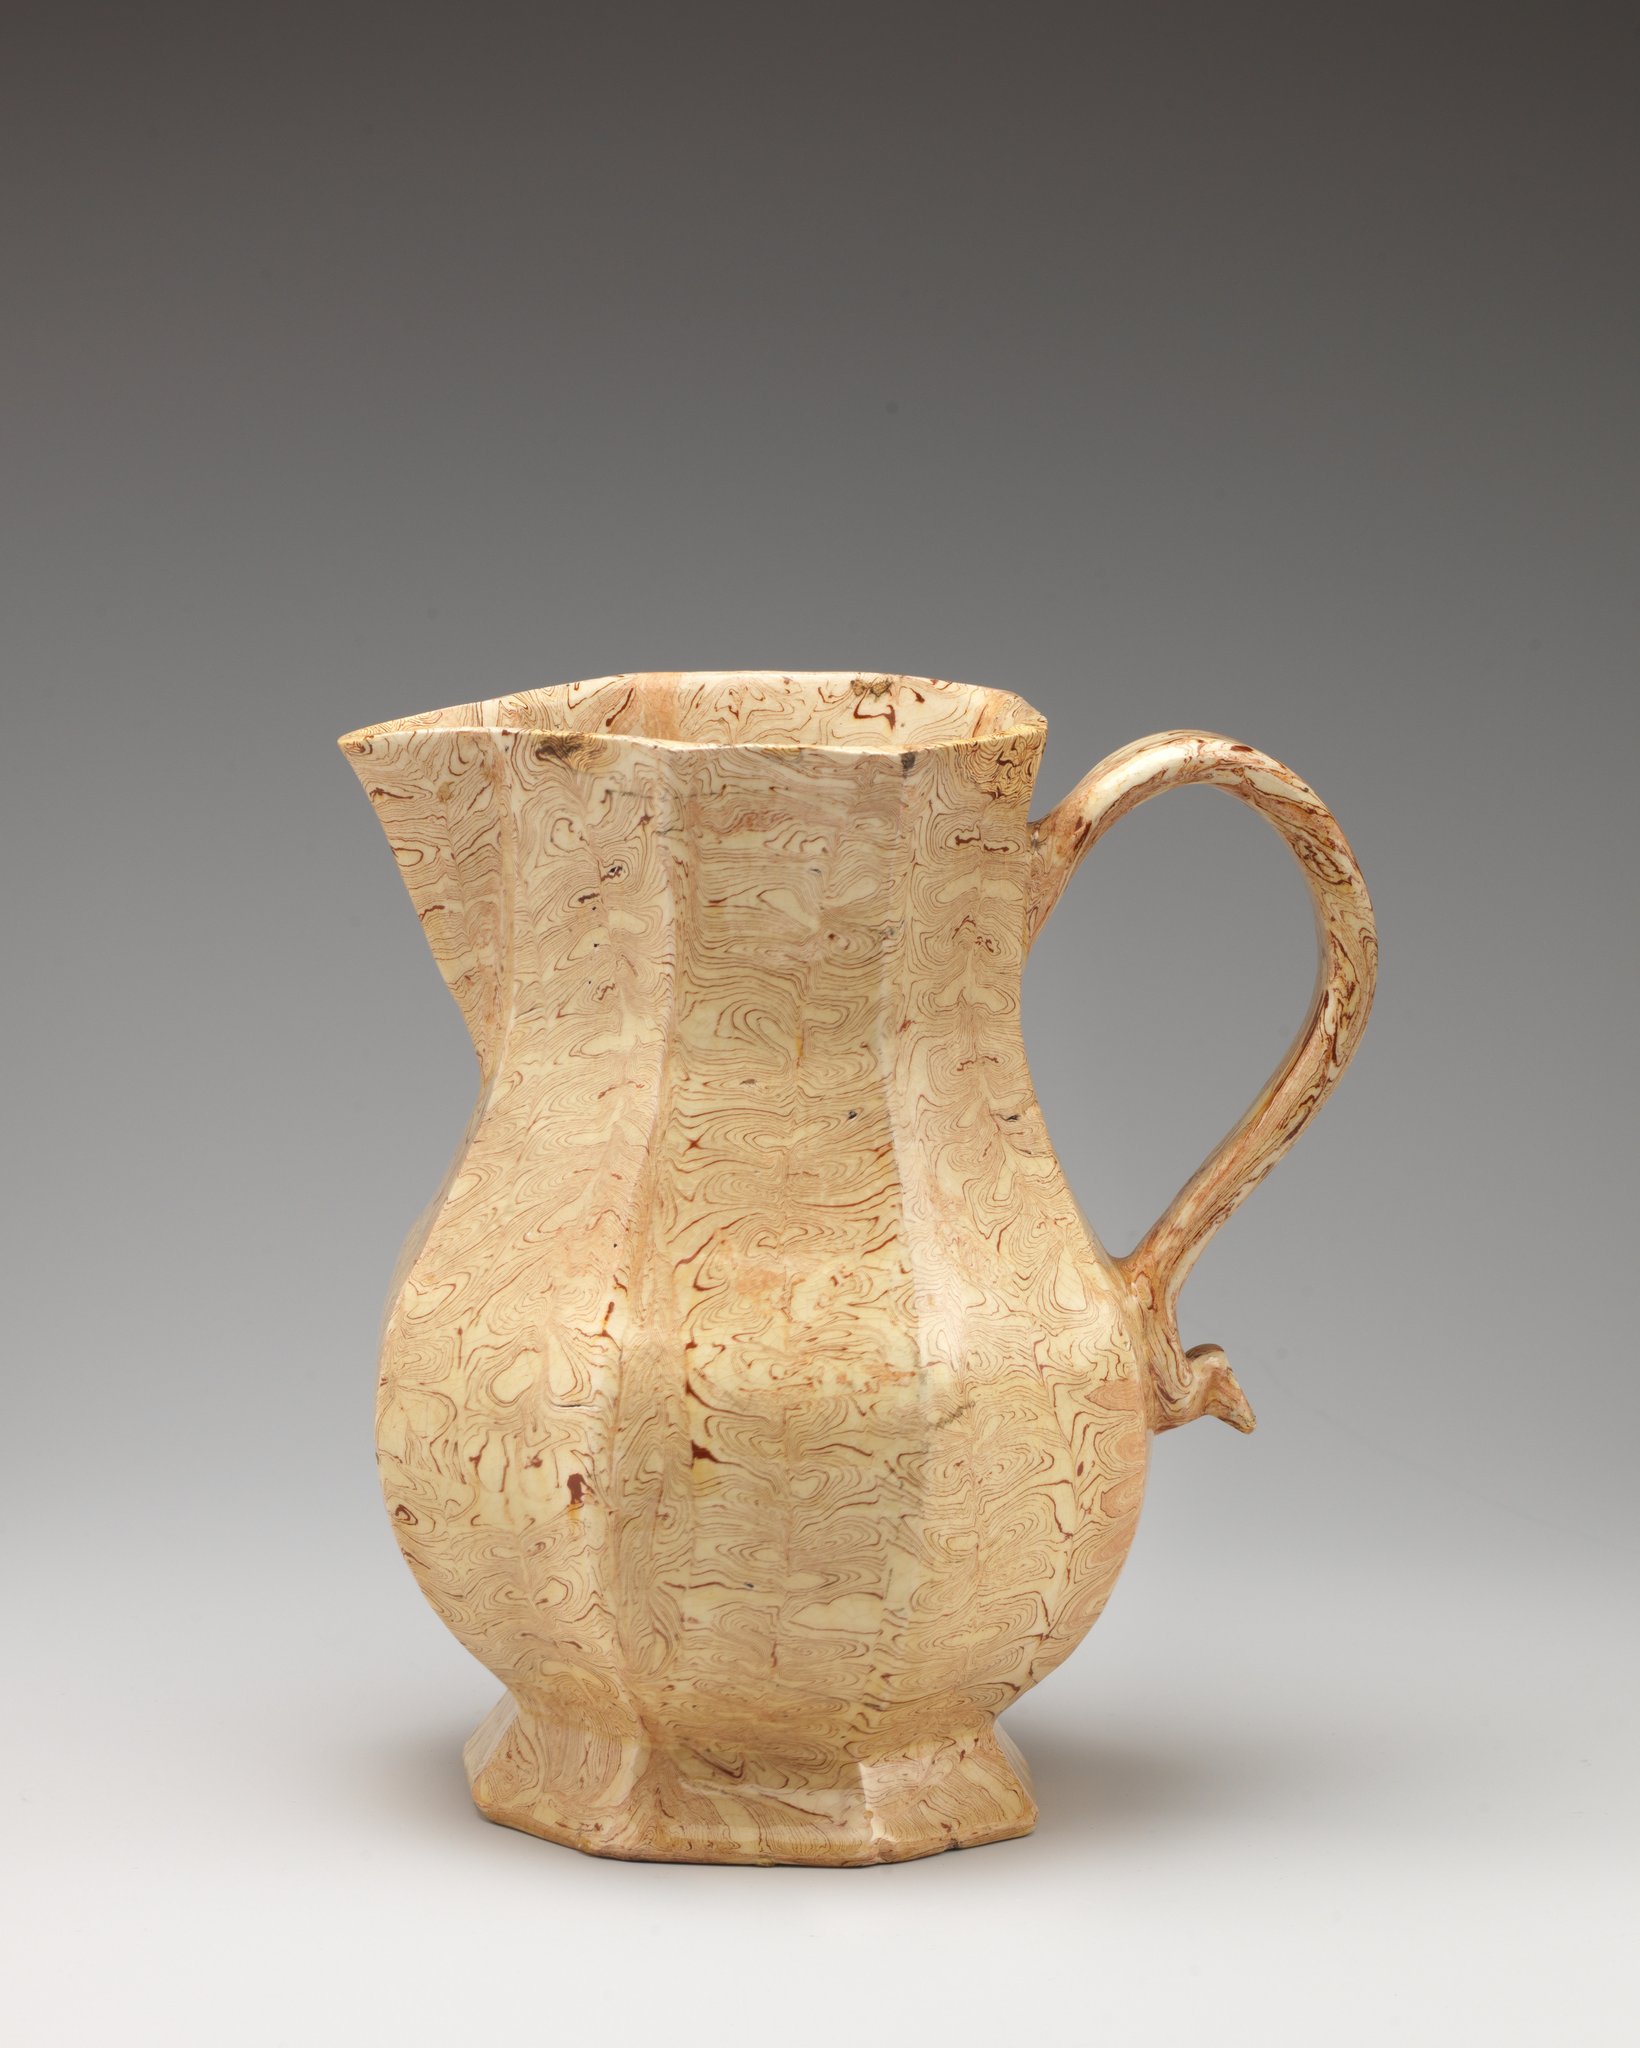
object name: jug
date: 1745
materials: earthenware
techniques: glazing